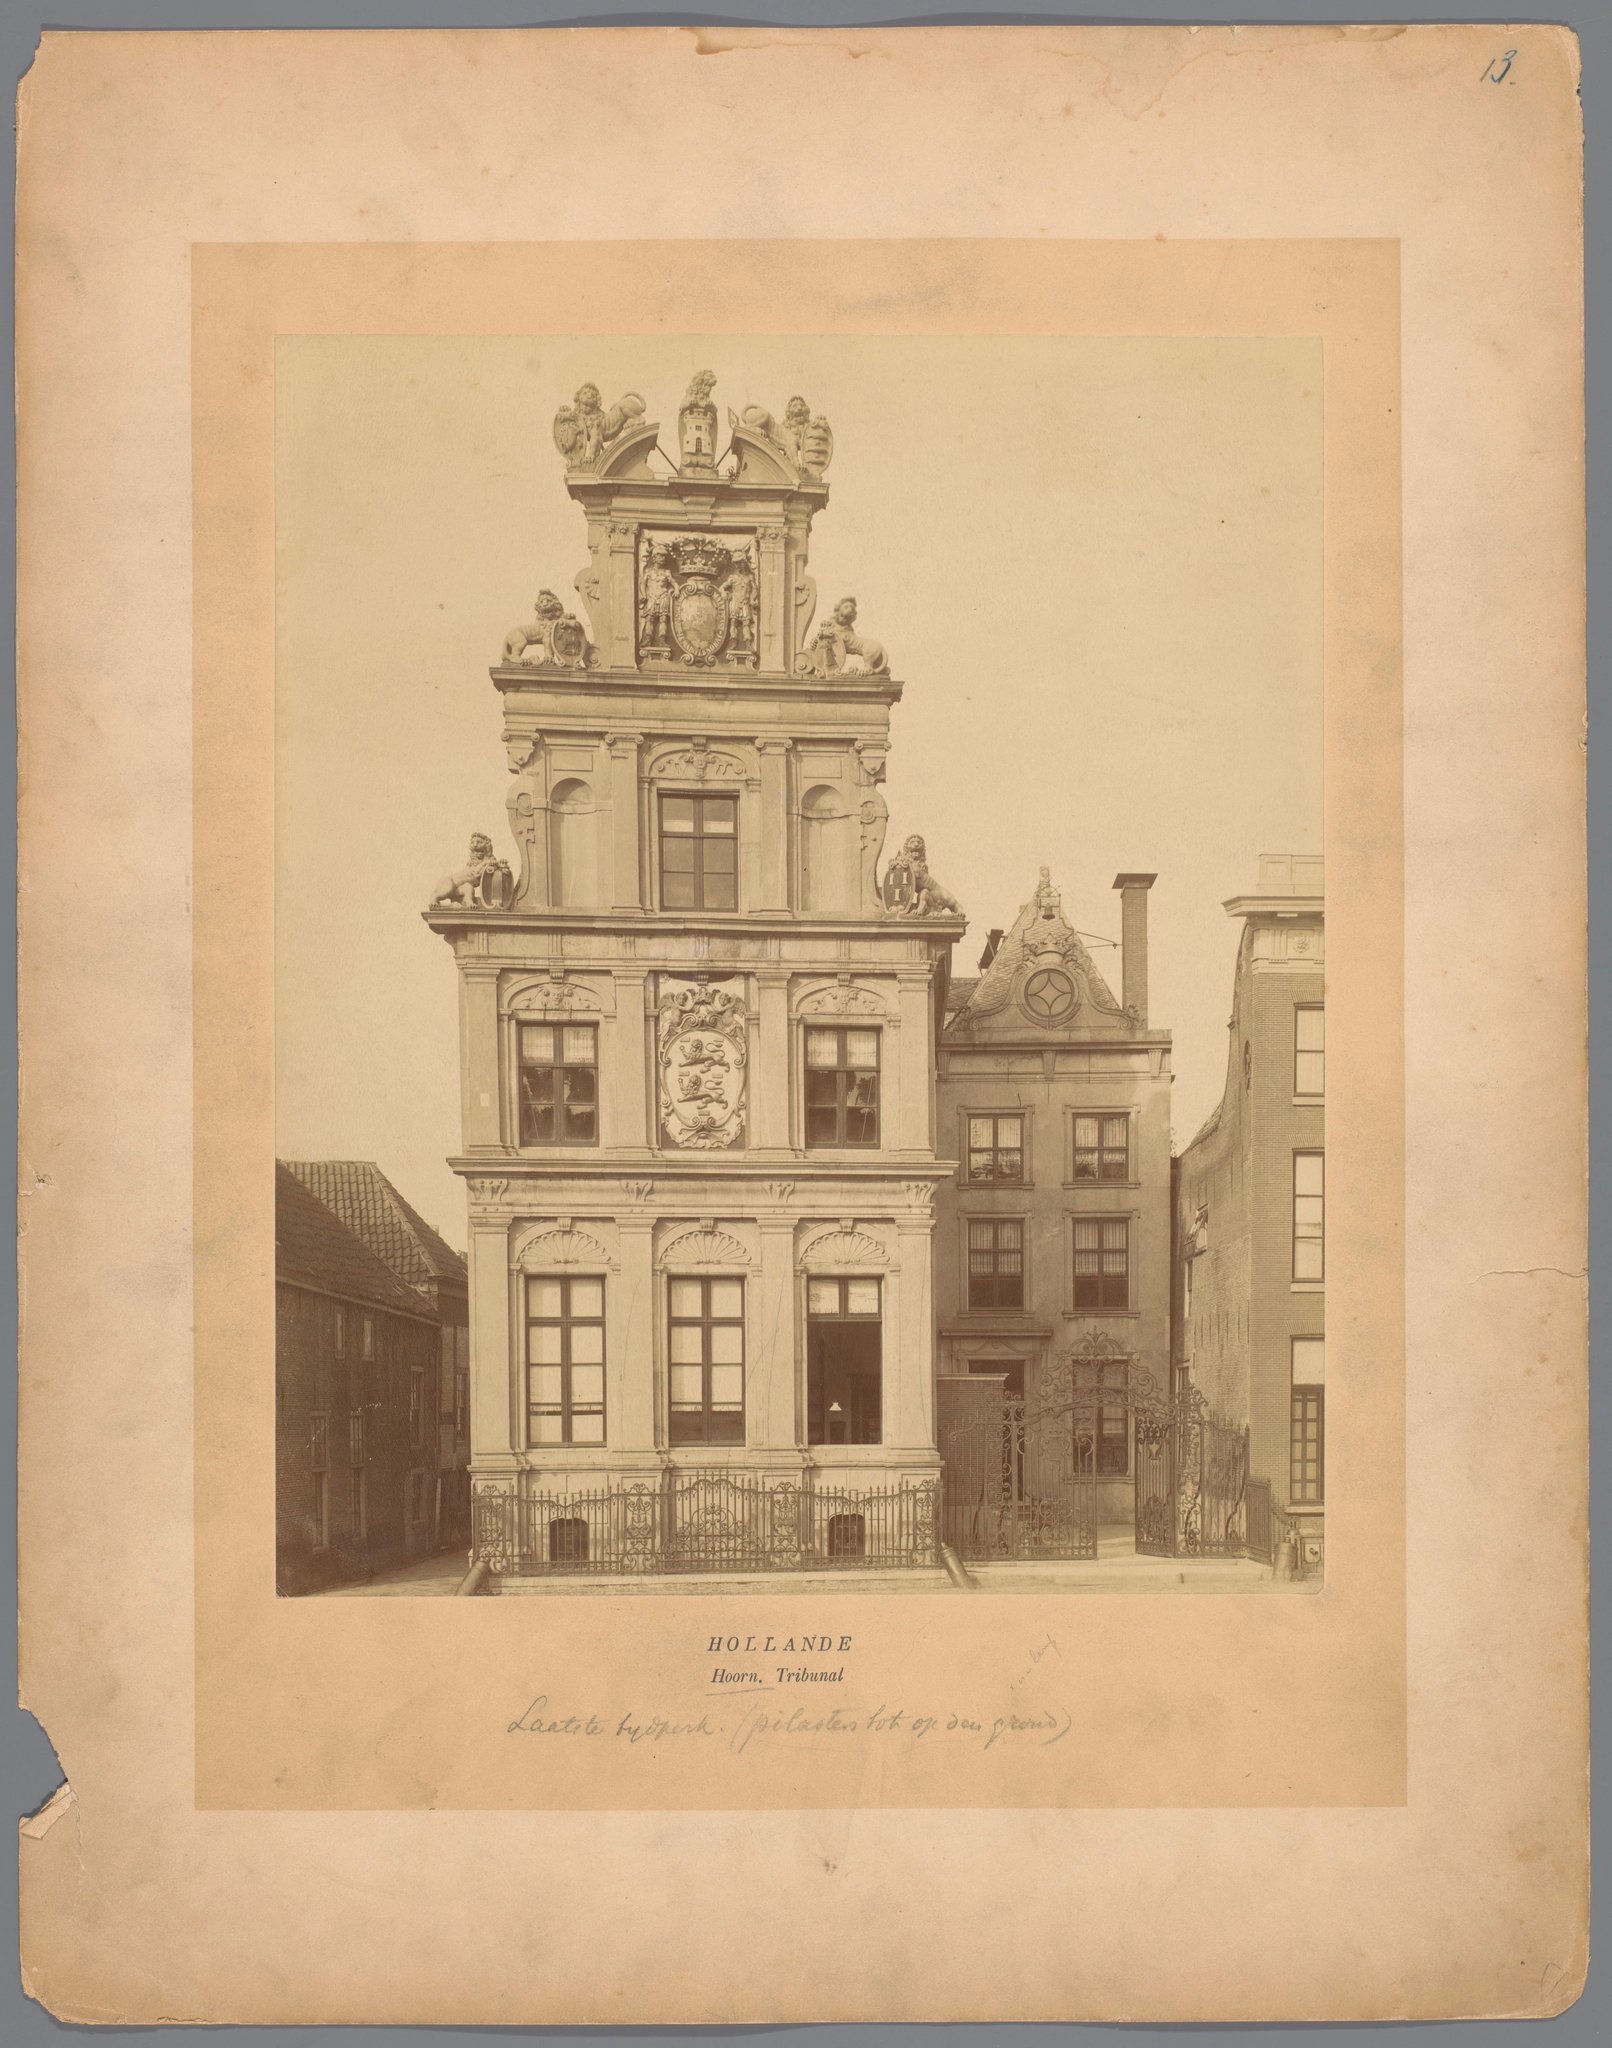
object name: photograph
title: Exterieur van de rechtbank te Hoorn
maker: Anonymous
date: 1875-1900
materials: cardboard, photographic support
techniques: albumen print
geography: hoorn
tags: court building, façade (of house or building)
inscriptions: collector's mark: Lugt 3937, inscription: ‘Laatste tijdperk. (pilasters tot op den grond)’, inscription: ‘HOLLANDE Hoorn. Tribunal’